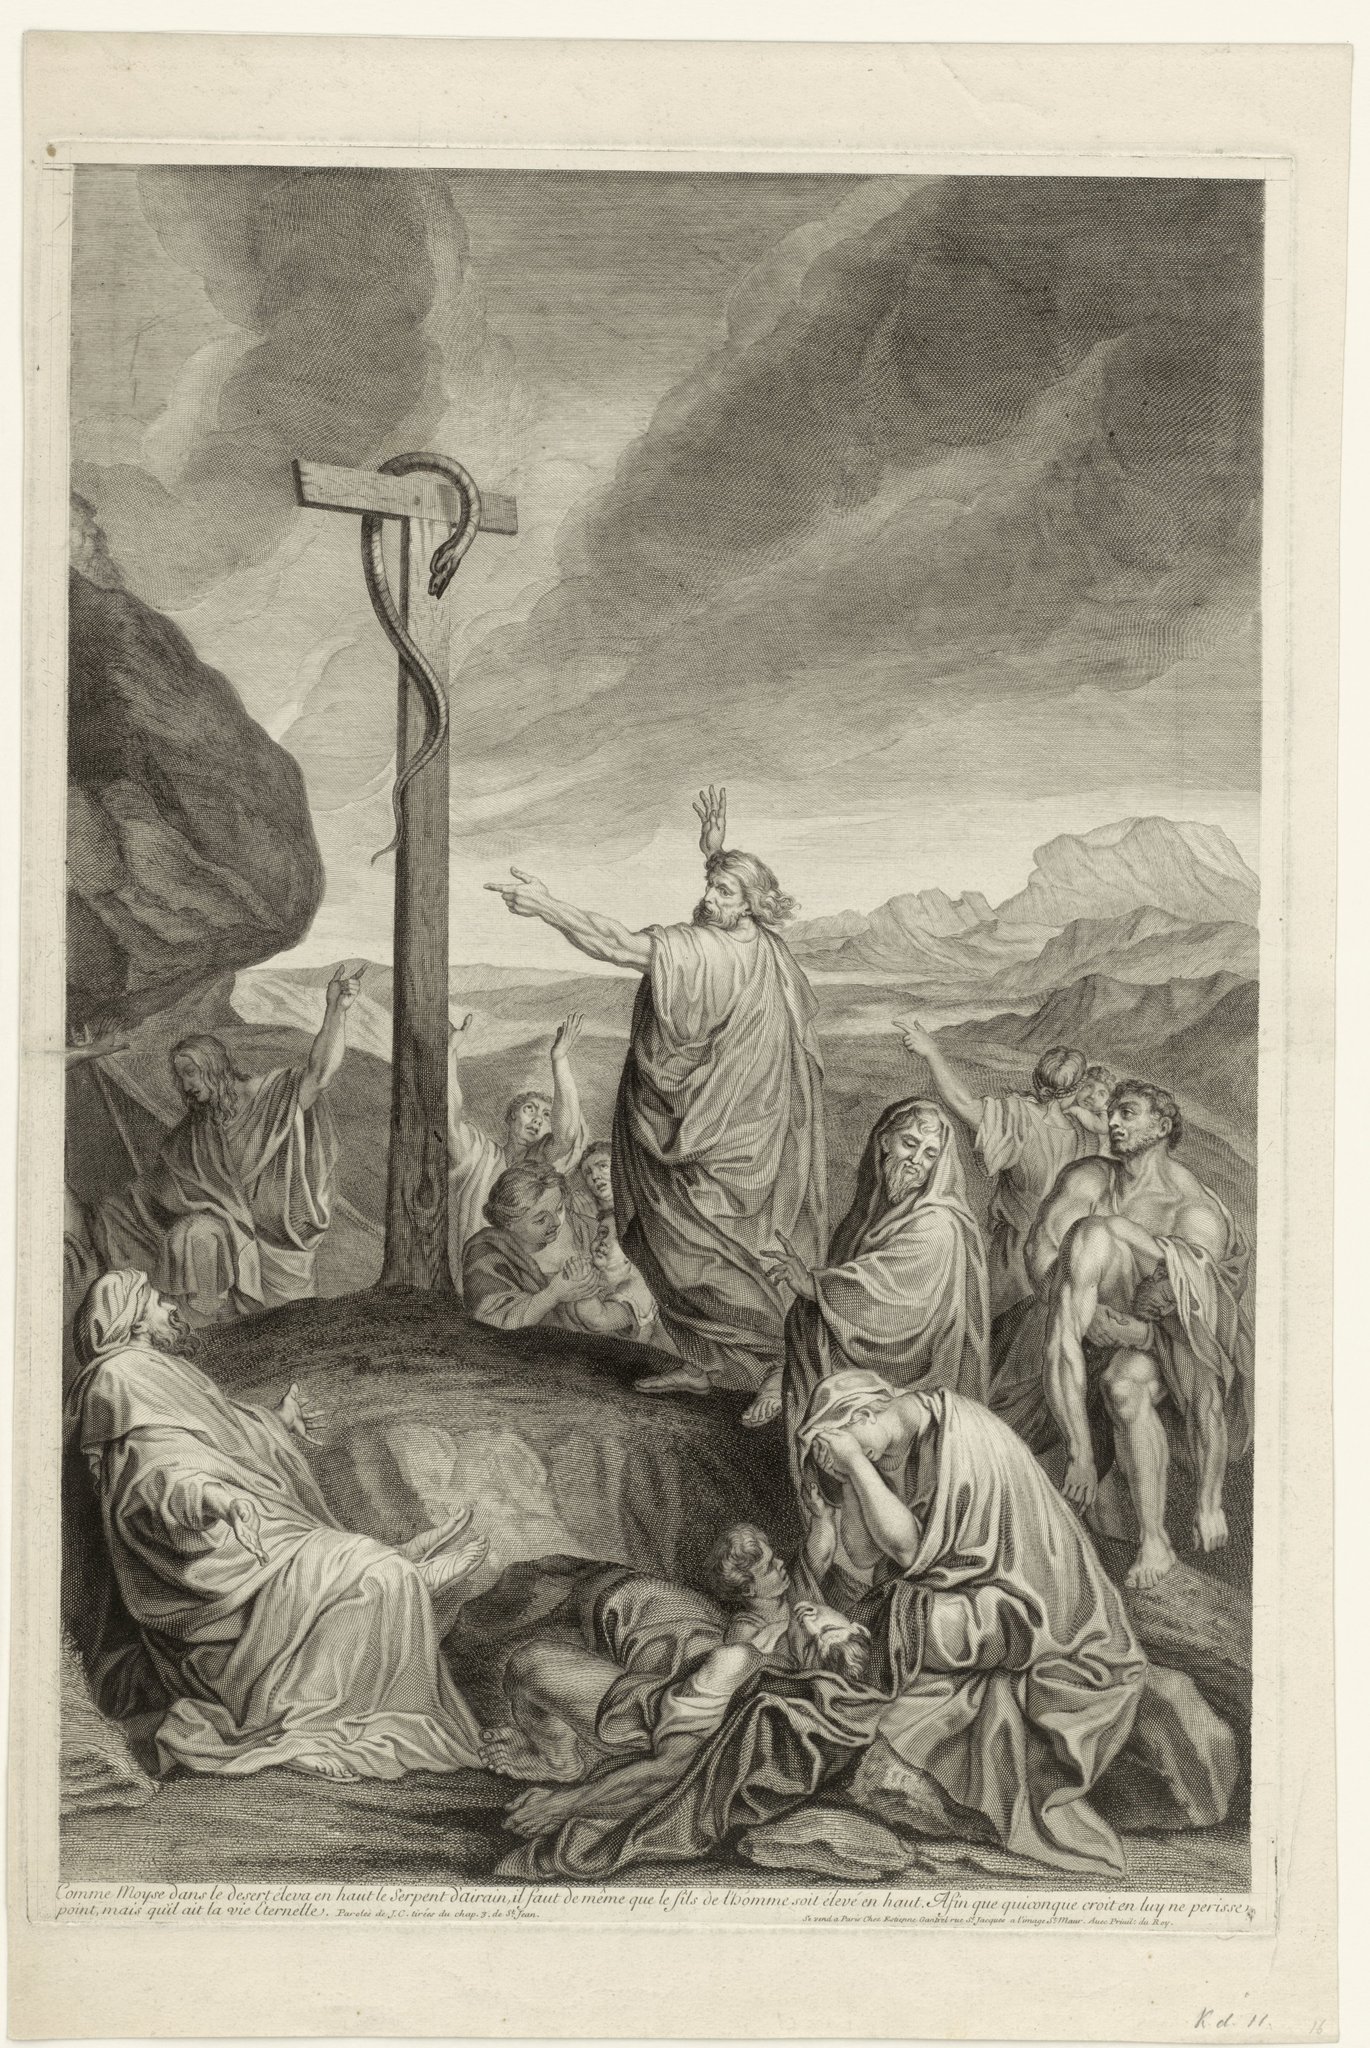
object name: print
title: De oprichting van de koperen slang (linker helft)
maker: antoine masson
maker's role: print maker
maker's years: 1636-1700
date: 1646-1700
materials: paper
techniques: engraving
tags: the brazen serpent (numbers 21:4-9)